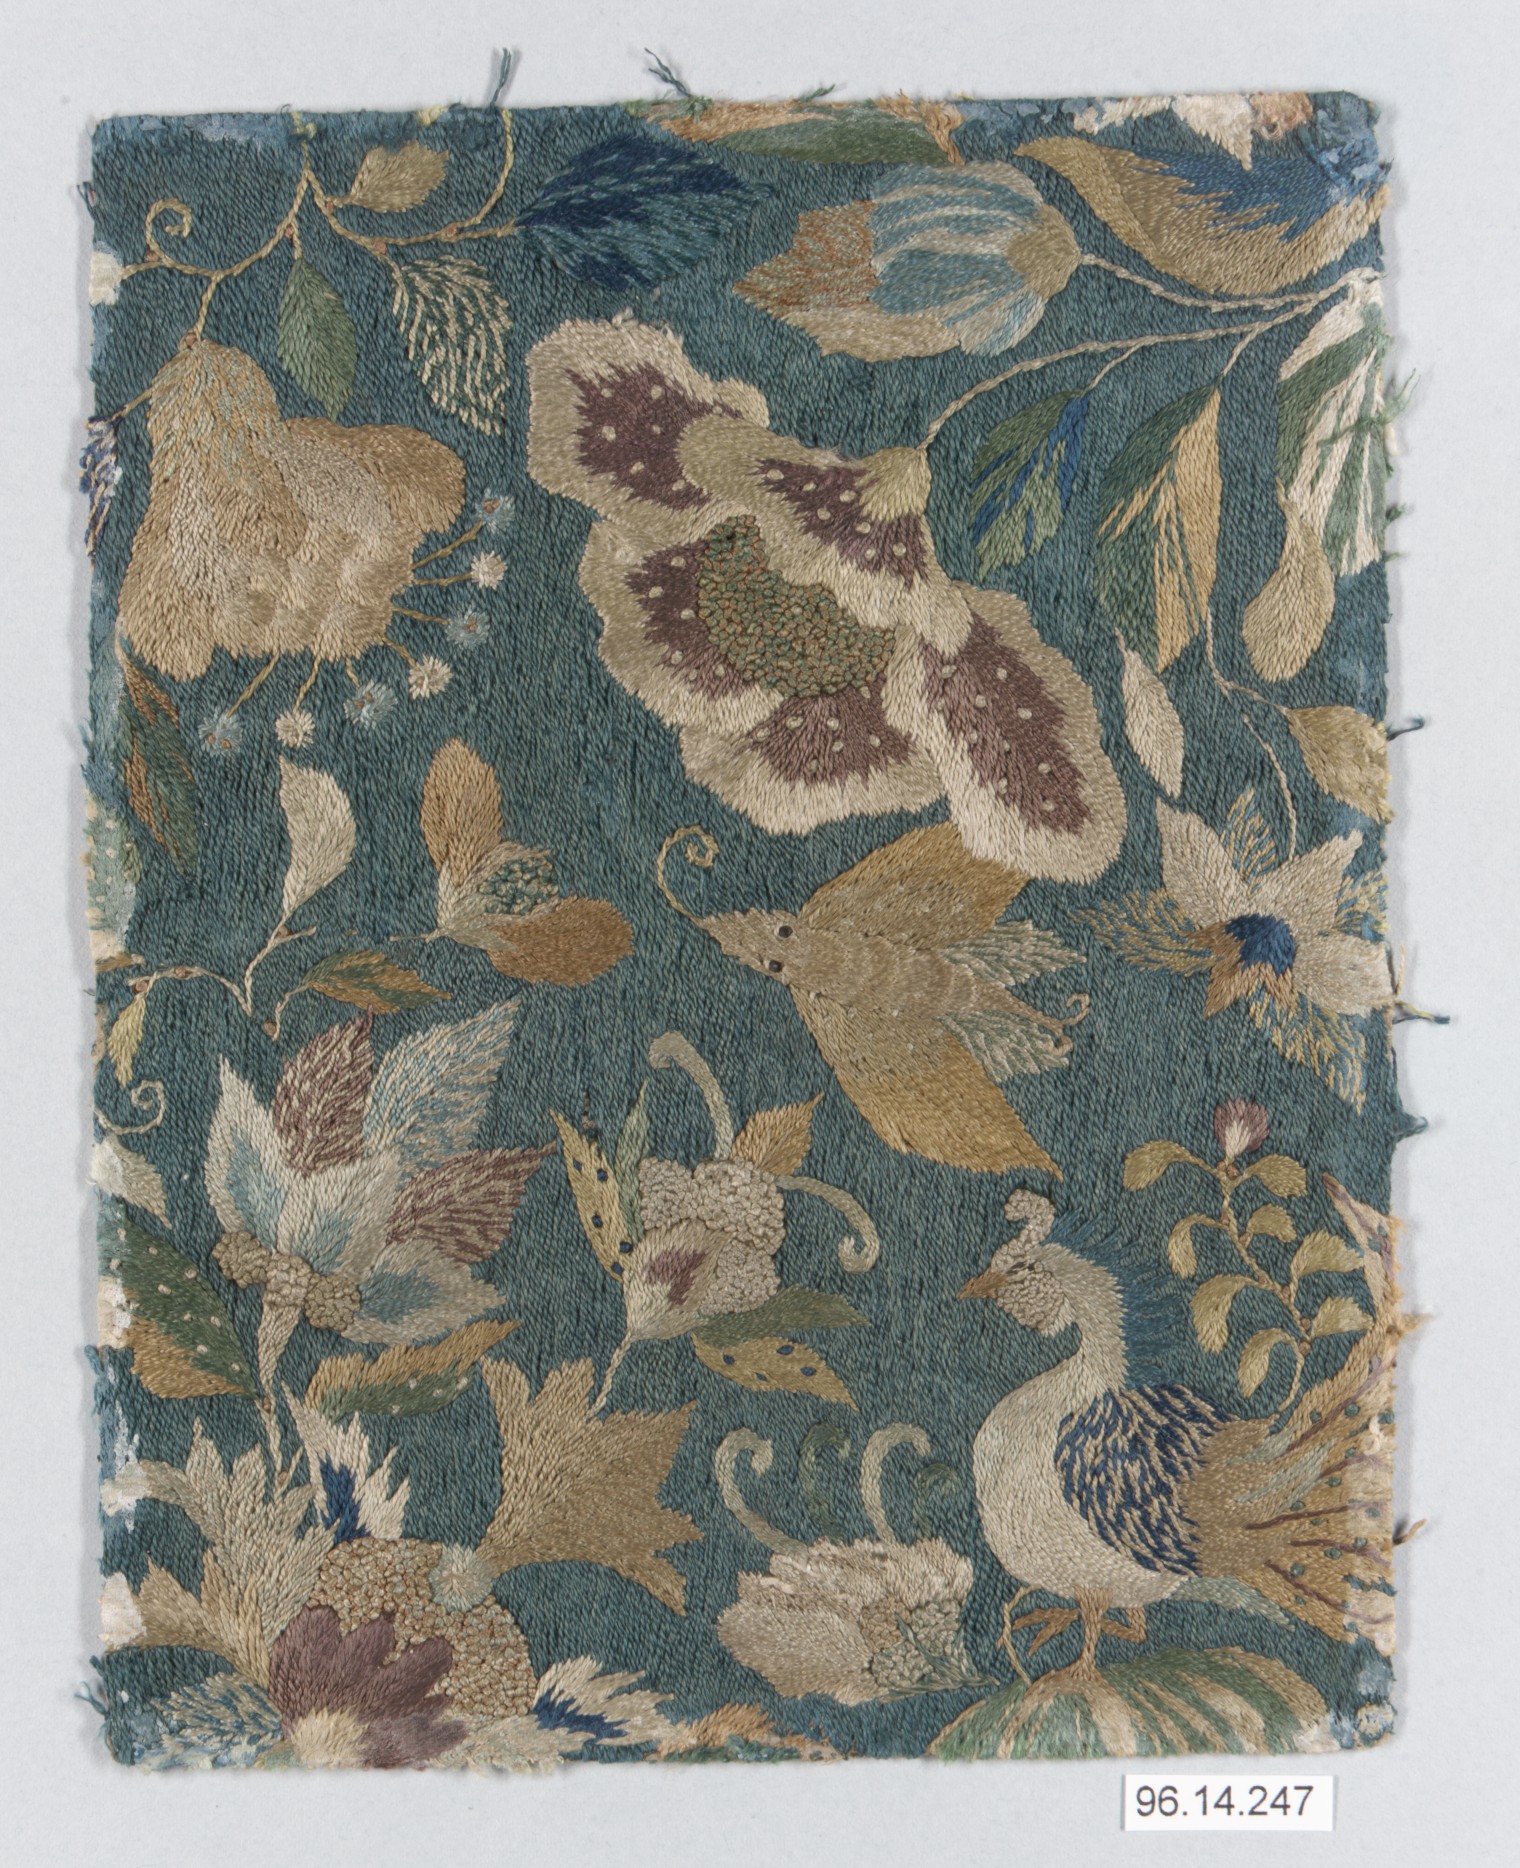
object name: piece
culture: japanese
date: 1701-1800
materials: paper, silk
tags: birds,flowers